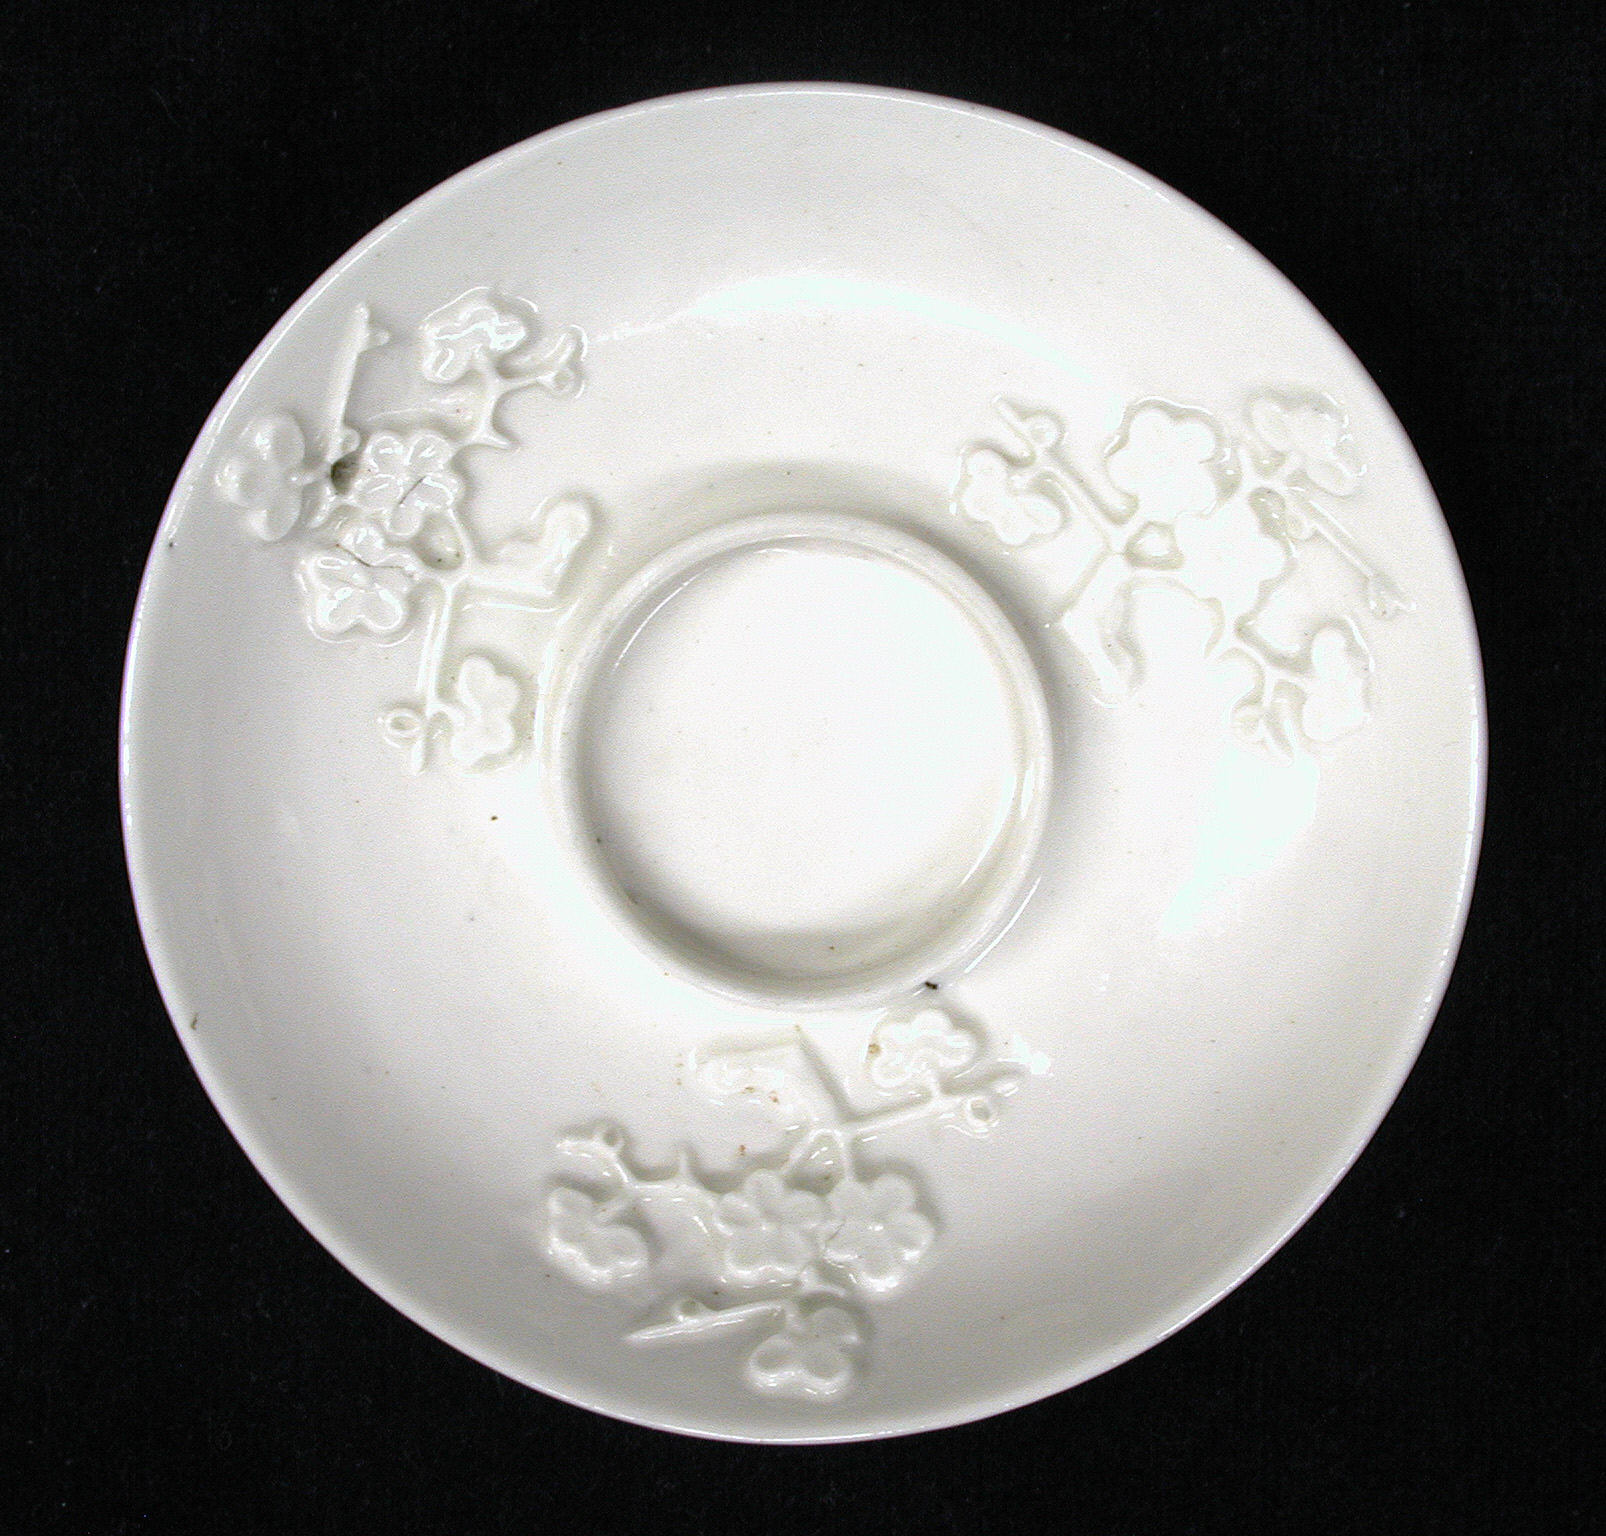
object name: saucer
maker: mennecy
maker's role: factory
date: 1750-1755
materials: soft paste porcelain